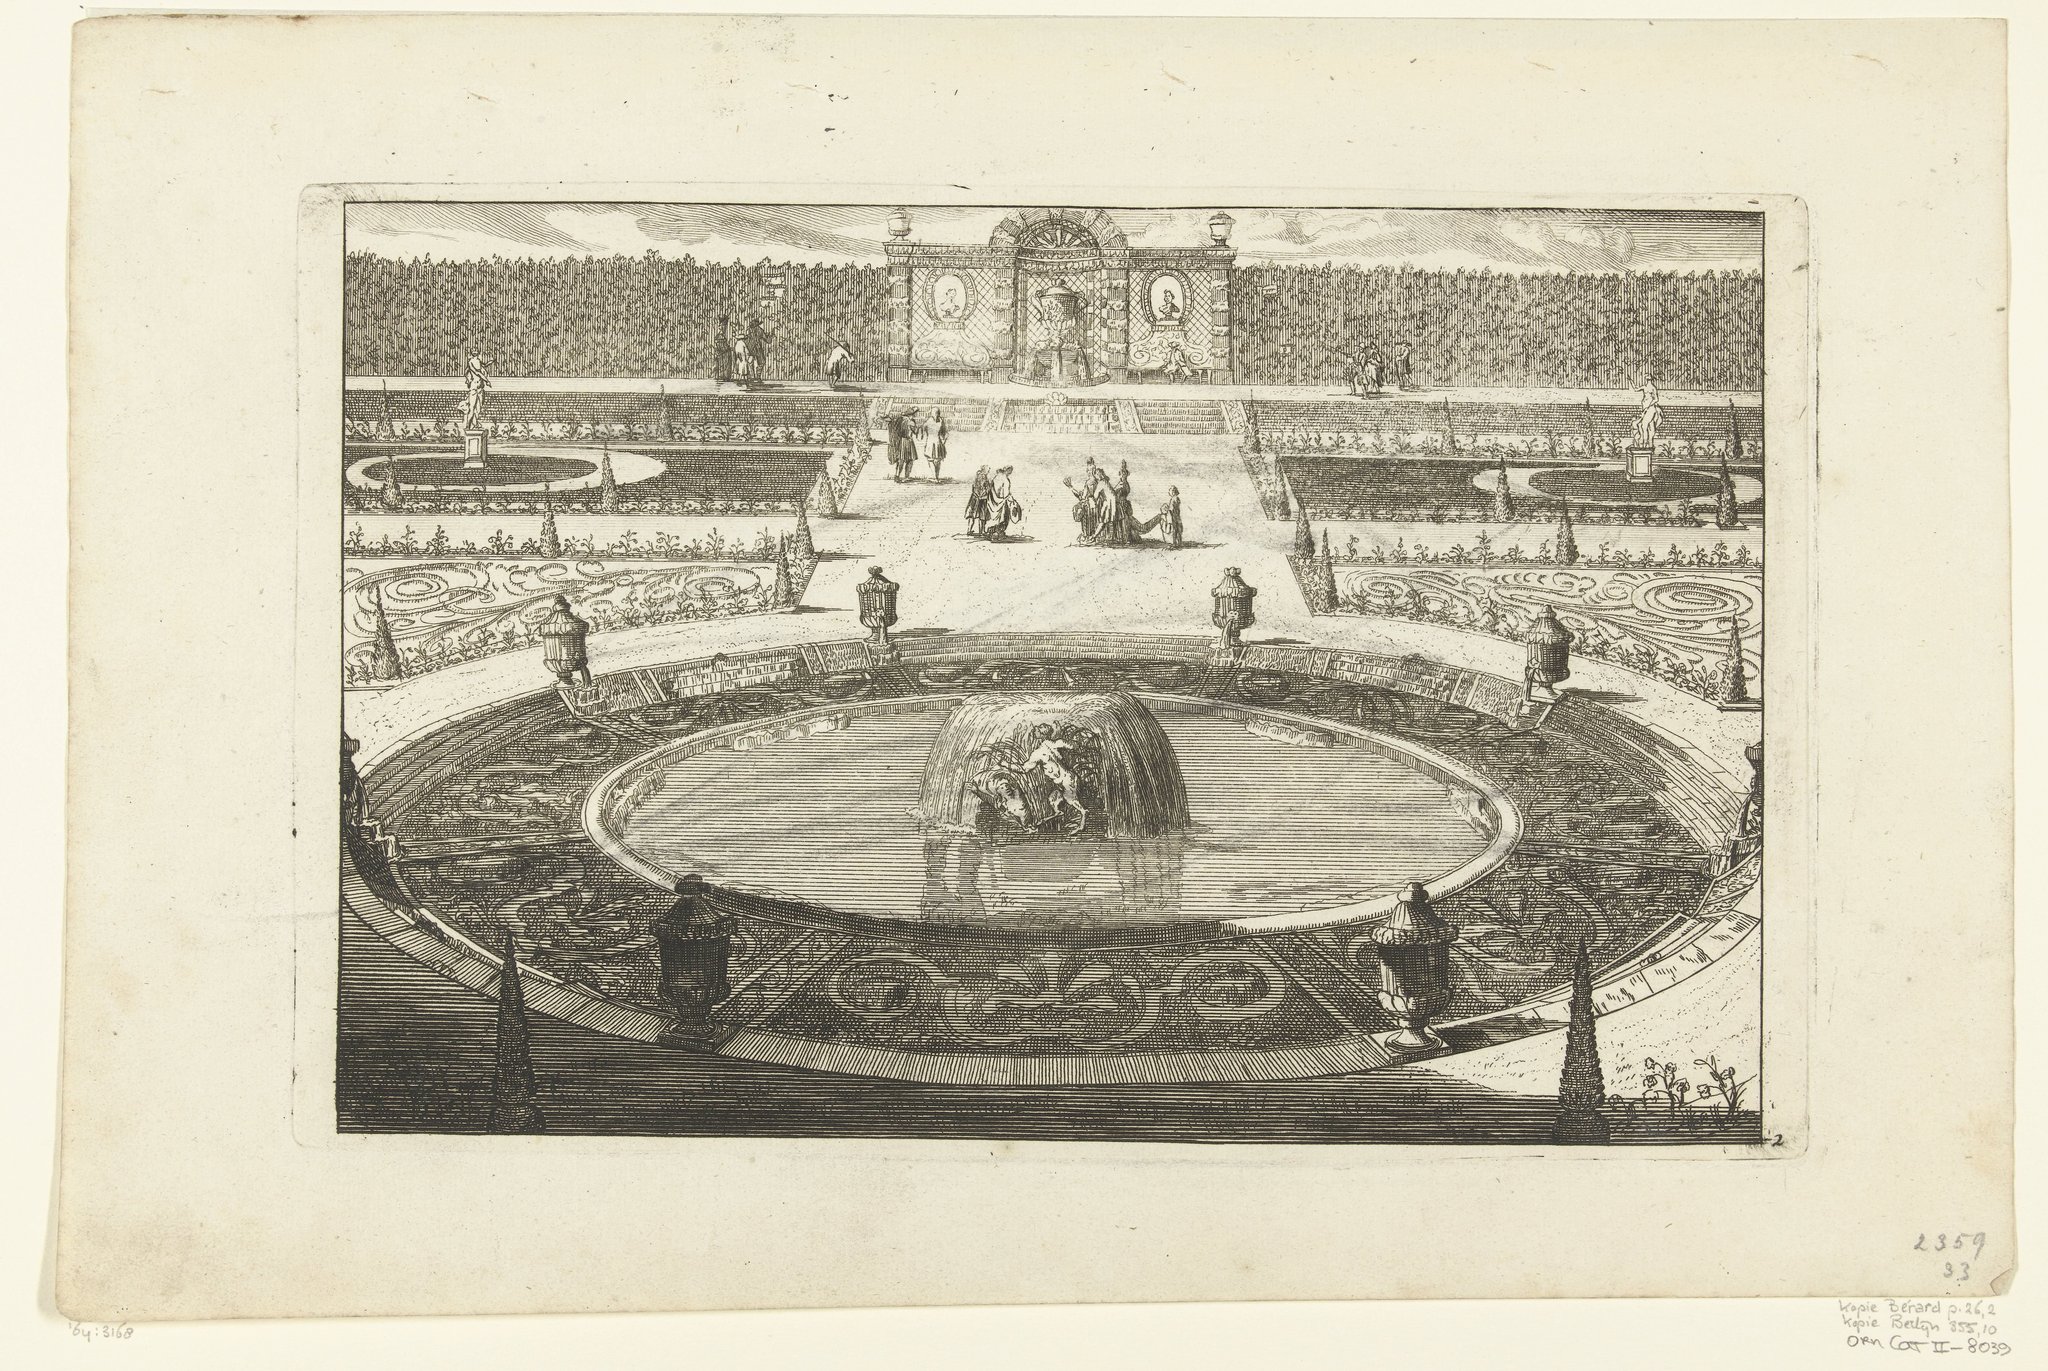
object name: ornament print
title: Nova Fontium Delineatio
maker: Anonymous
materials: paper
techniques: etching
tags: garden fountain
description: Op de voorgrond is een groot rond bassin te zien, omringd door een cirkelvormige parterre. In het midden is een fontein met een sater en een nimf. Kopie naar blad uit serie Liure de fontaines uitgegeven door Daniel Marot.